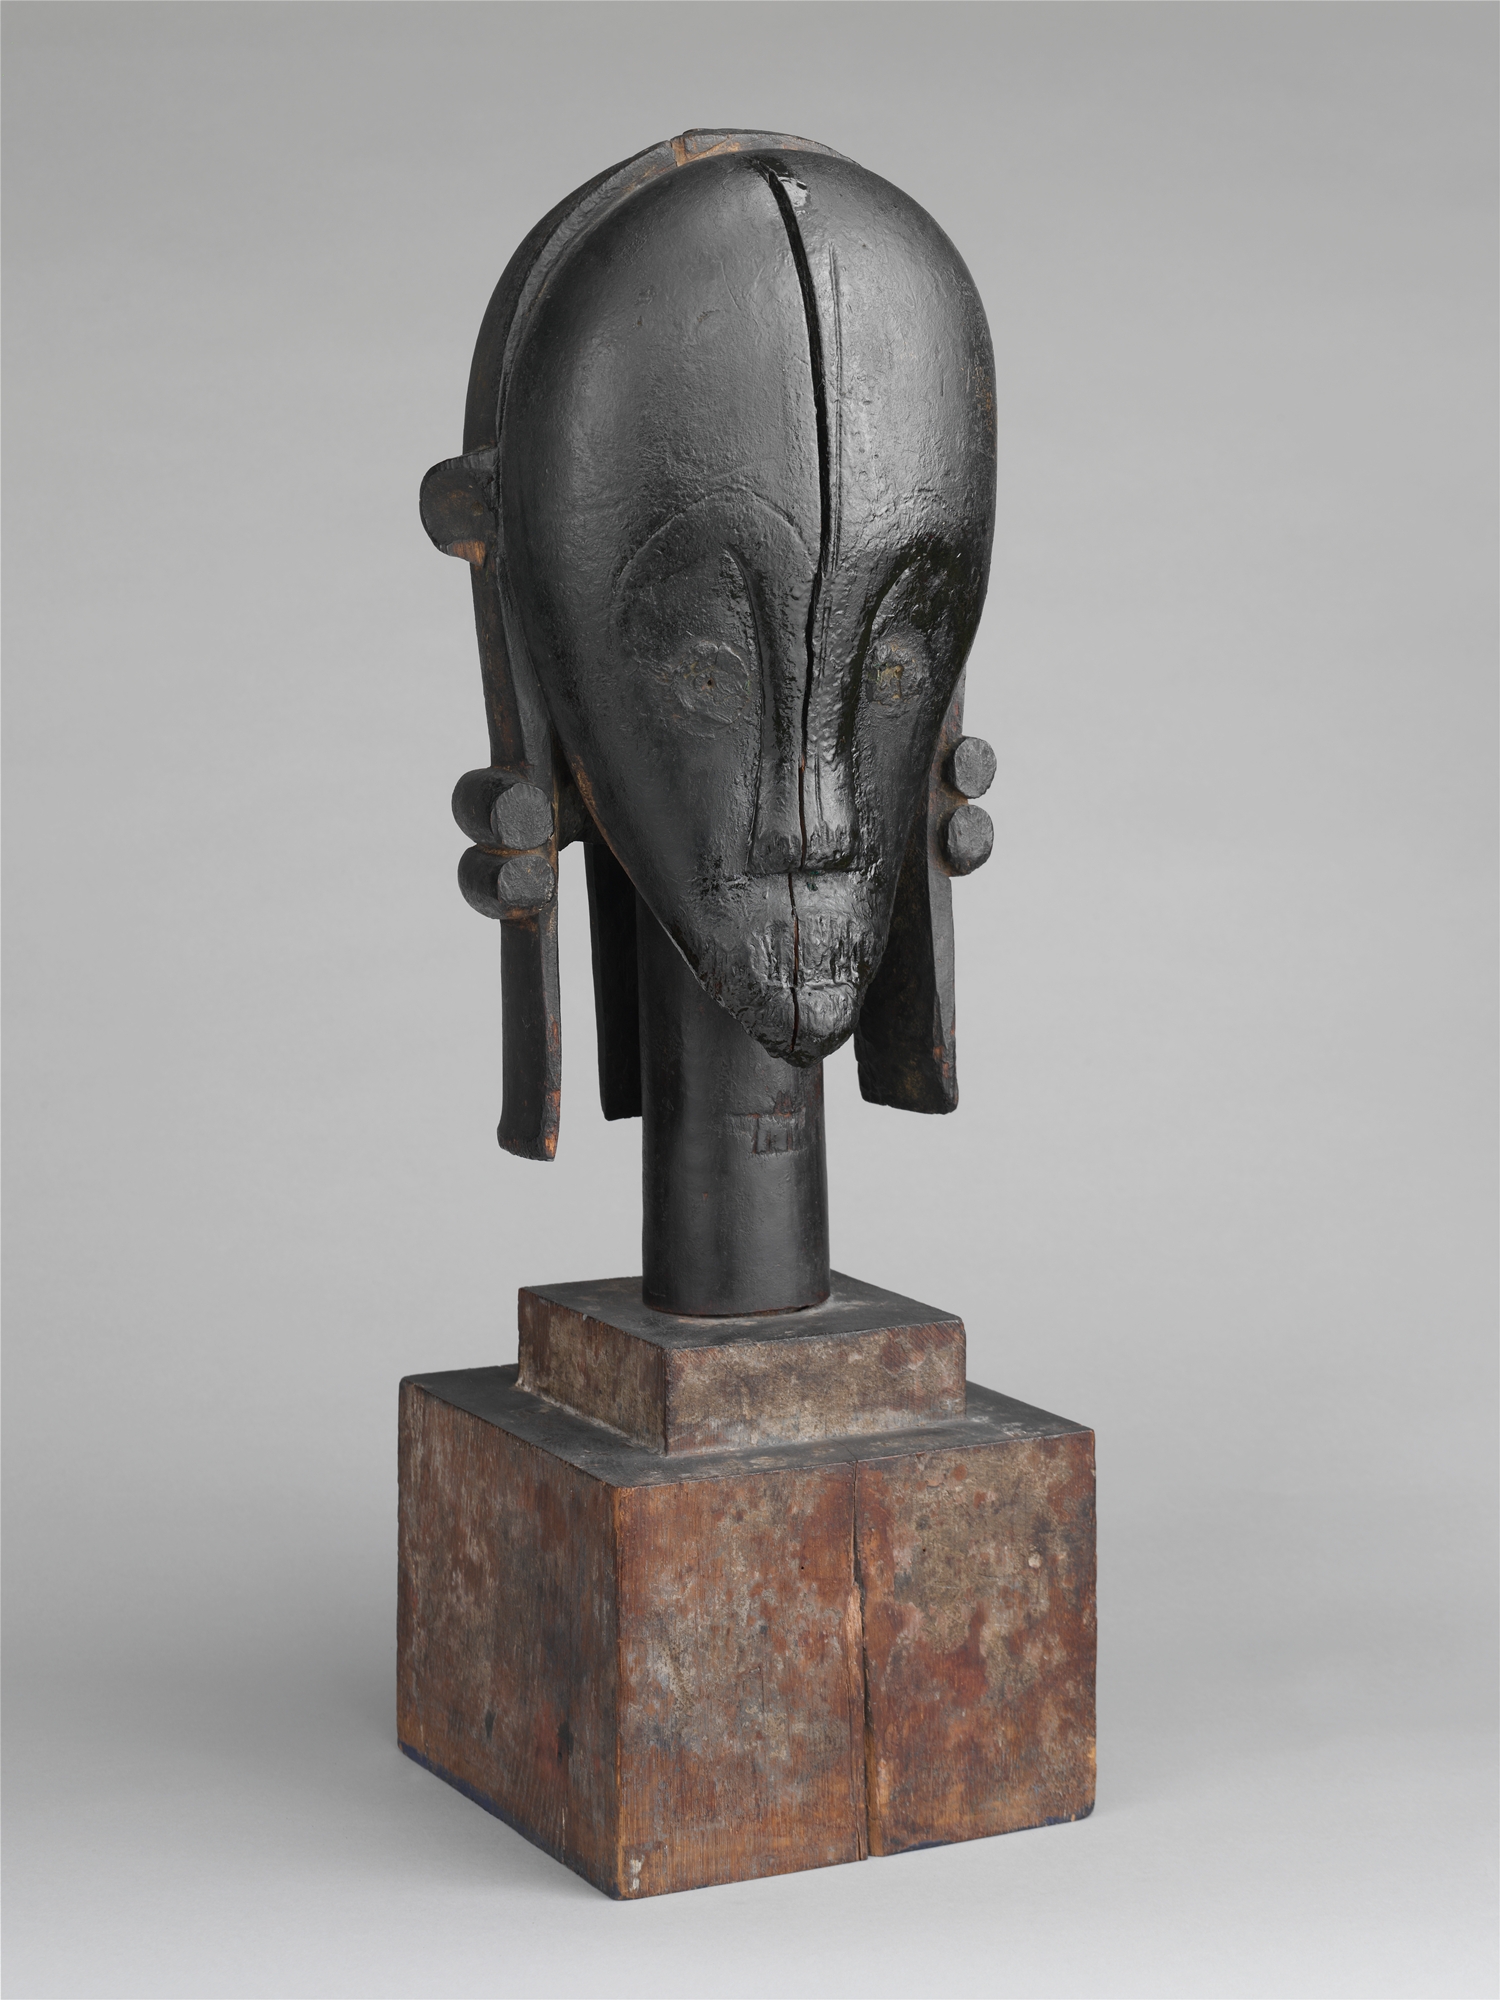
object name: head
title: Nlô byeri (reliquary guardian head)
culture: fang-betsi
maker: betsi-fang artist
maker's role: artist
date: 1801-1900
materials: copper alloy, oil, wood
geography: gabon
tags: heads